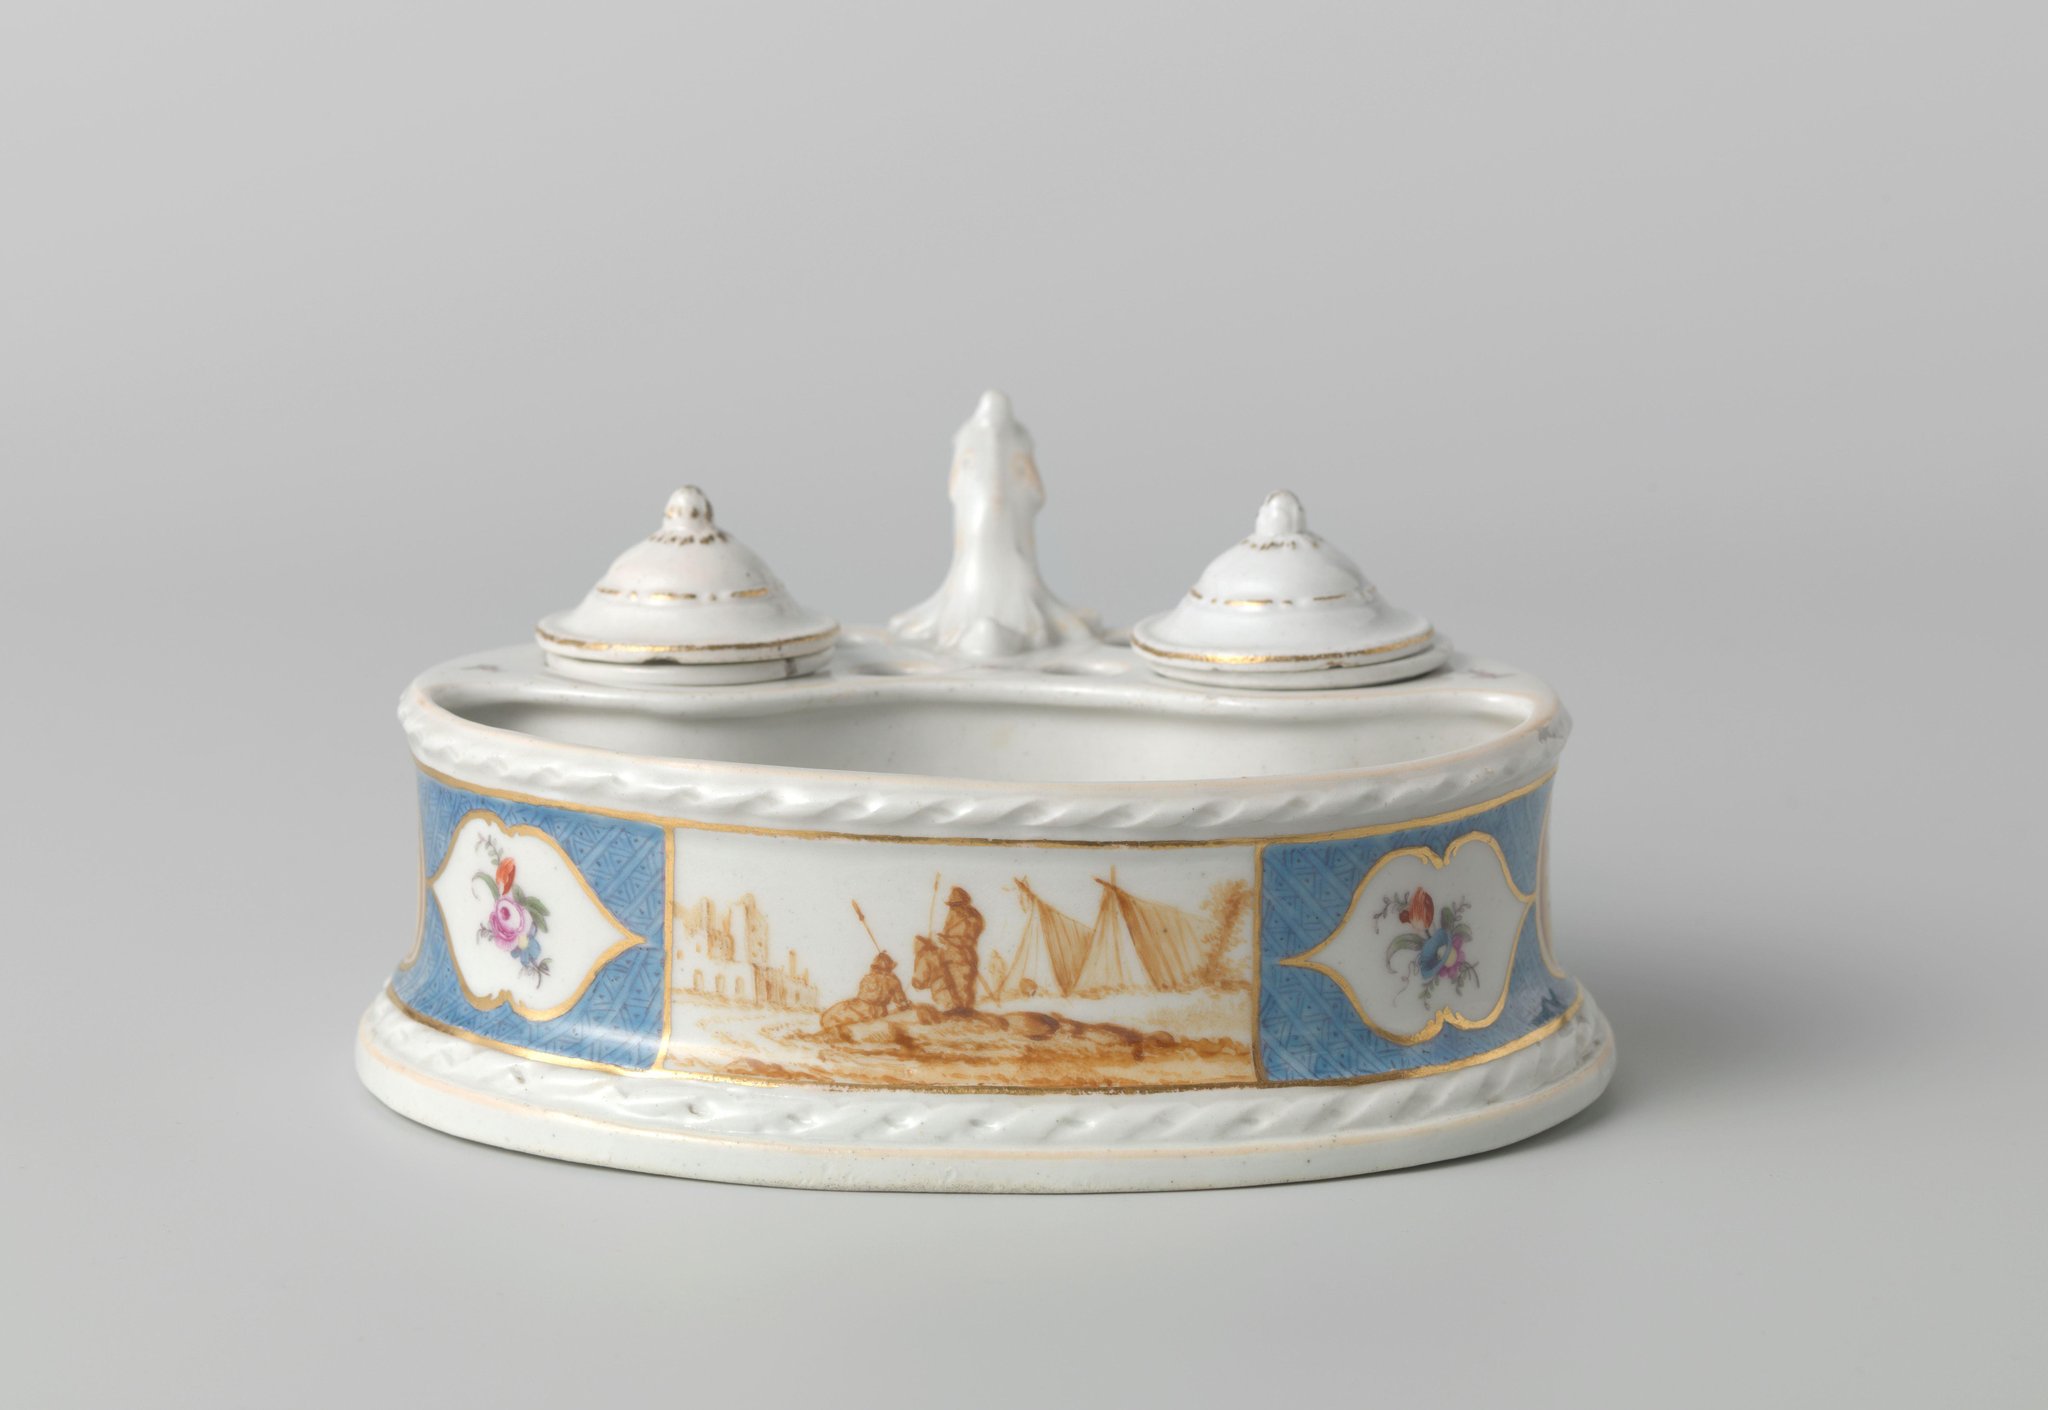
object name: sander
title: Zandstrooier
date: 1778-1782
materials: porcelain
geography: loosdrecht